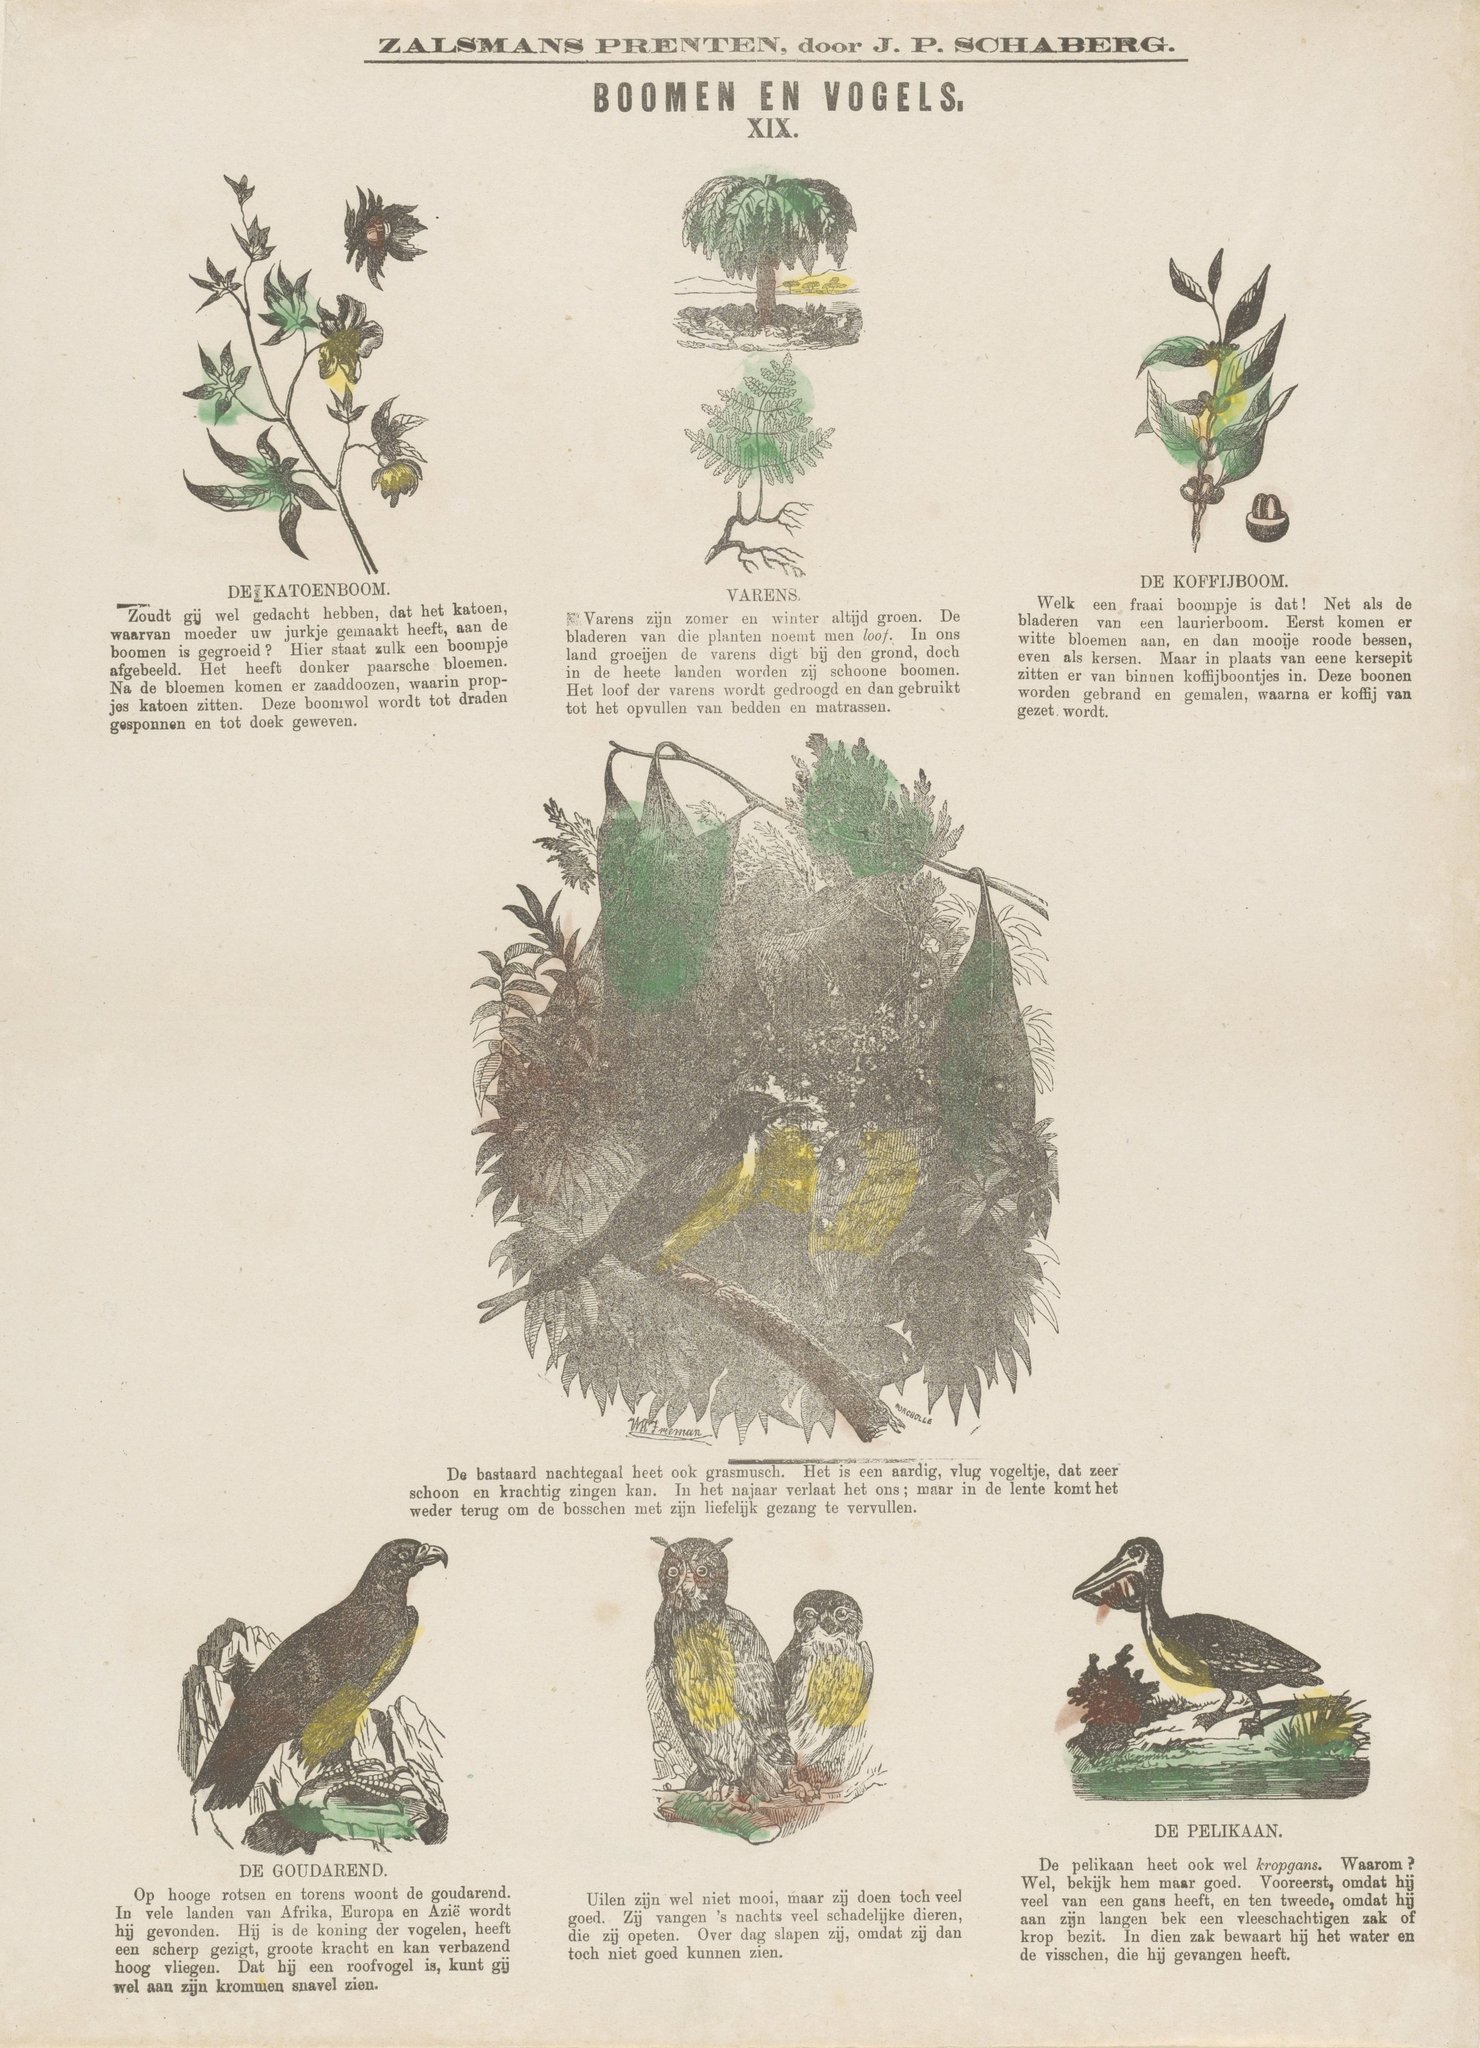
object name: popular print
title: Zalmans prenten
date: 1869-1882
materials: paper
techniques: colour, letterpress printing, engraving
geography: kampen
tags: trees, trees (+ branch, stick), birds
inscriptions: collector's mark: Lugt 2760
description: Blad met 7 voorstellingen van takken, bomen en vogels. Onder elke voorstelling een onderschrift. Genummerd midden boven: XIX.